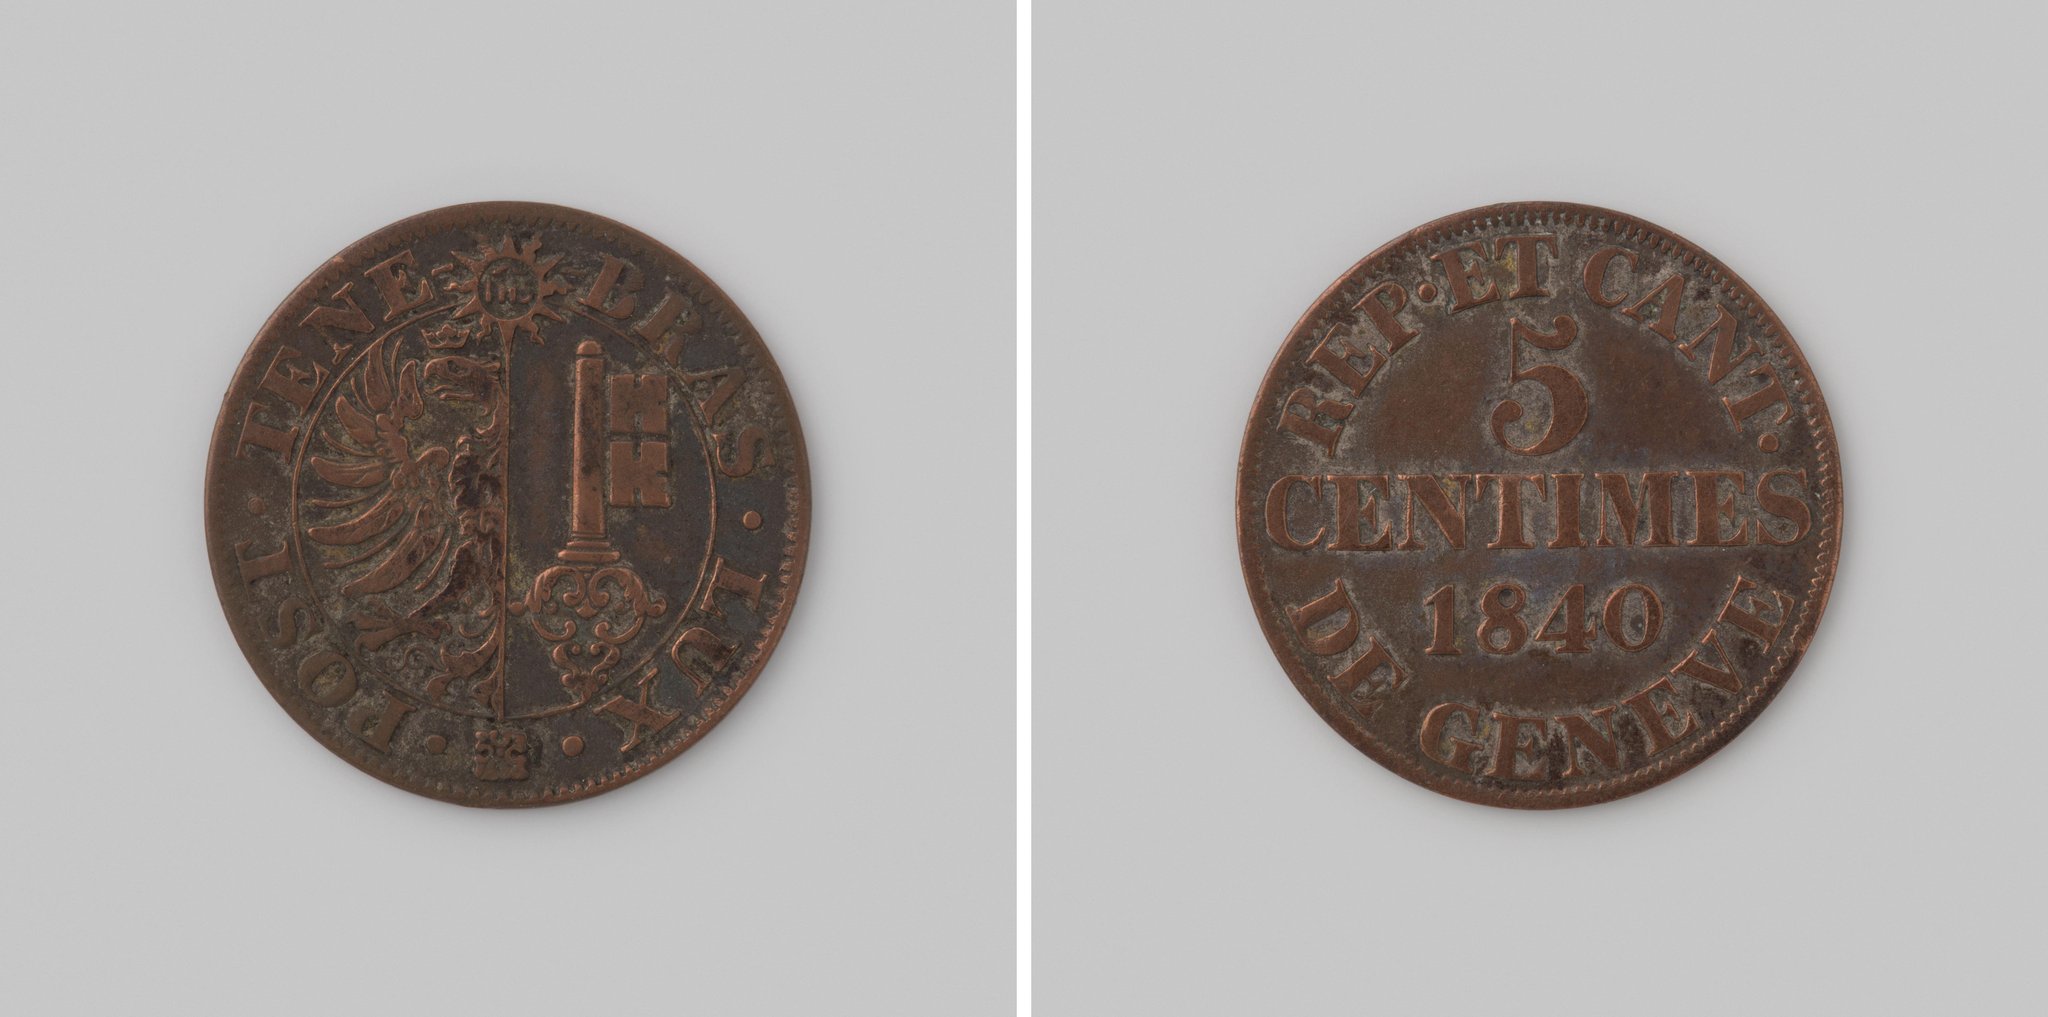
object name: vijf centime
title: 5 centimes uit het kanton Geneve, 1840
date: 1840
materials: copper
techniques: striking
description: Koperen munt. Voorzijde: wapen van Geneve in het veld. Daarboven binnen stralende zon de letters I,H en S. Keerzijde: waarde-aanduiding in twee regels, waaronder jaartal. Gladde rand.